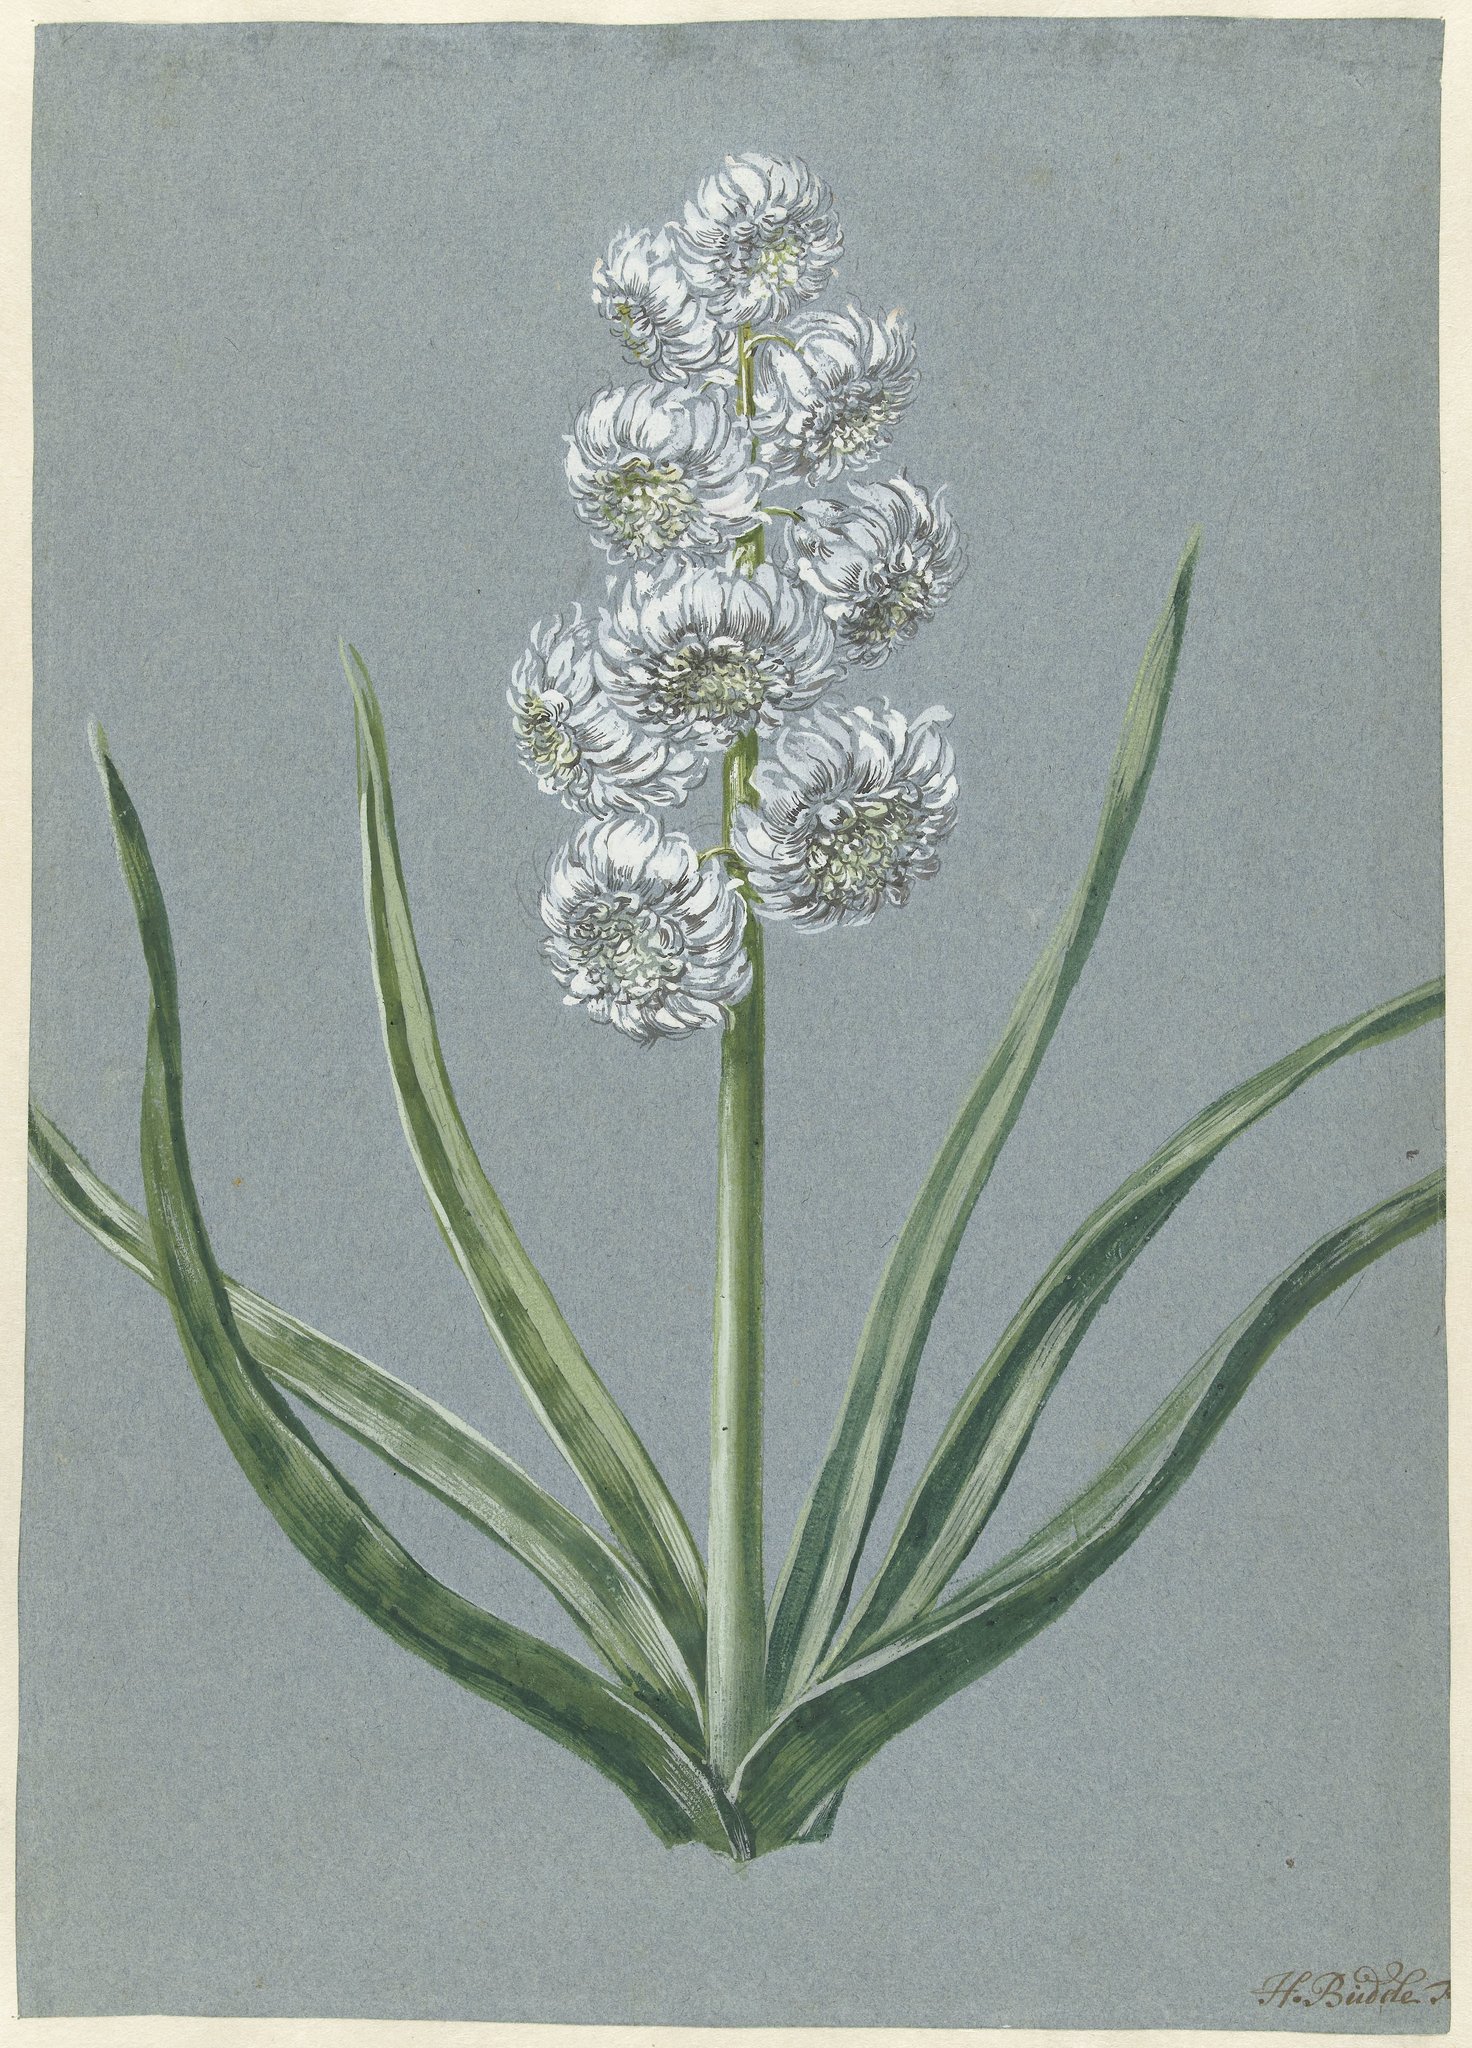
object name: watercolor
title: Hyacint Markgraaf Karel van Baden Durlach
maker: hendrik budde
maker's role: draughtsman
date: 1720-1729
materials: paint, paper, watercolor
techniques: brush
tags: flowers: hyacinth